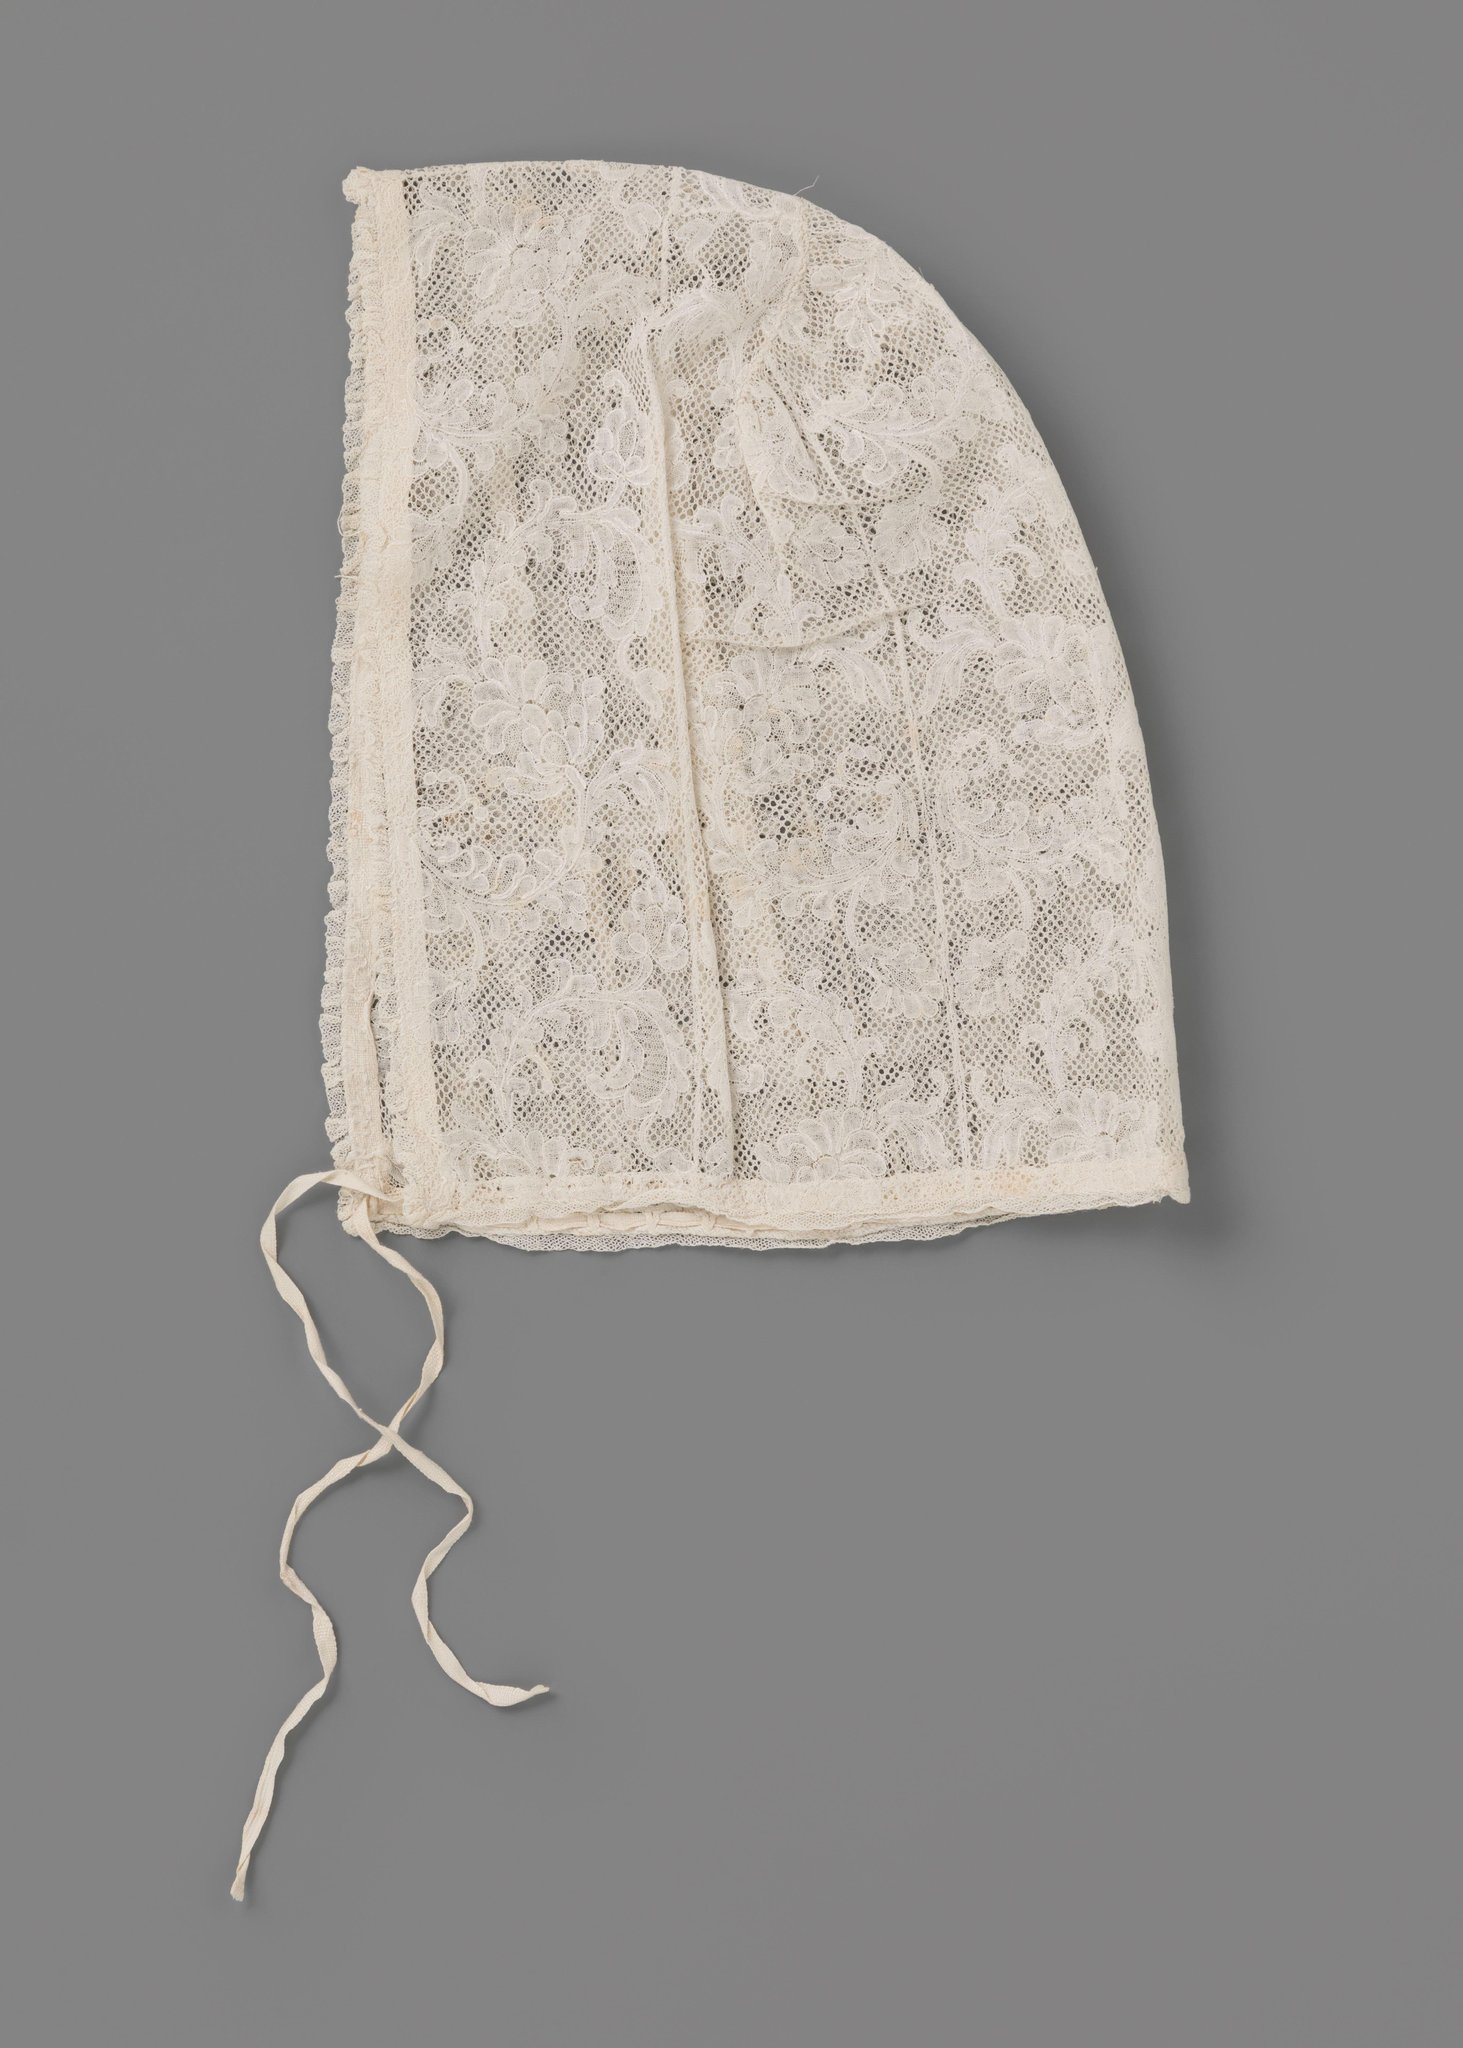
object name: cap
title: Muts van zes stroken kloskant met bladeren en bloemen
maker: Anonymous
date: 1750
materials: linen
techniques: lace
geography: mechelen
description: Muts van zes stroken naturelkleurige kloskant, Mechelse kant. Het patroon heeft ranken en bloemen gemaakt in netslag en linnenslag en zijn met elkaar verbonden door een traliegrond, een vijfgaatjesgrond. De muts kan worden dichtgesnoerd door middel van een koord.